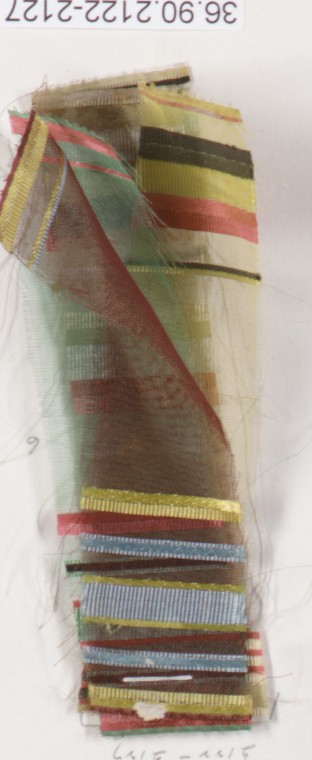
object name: piece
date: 1801-1900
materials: silk